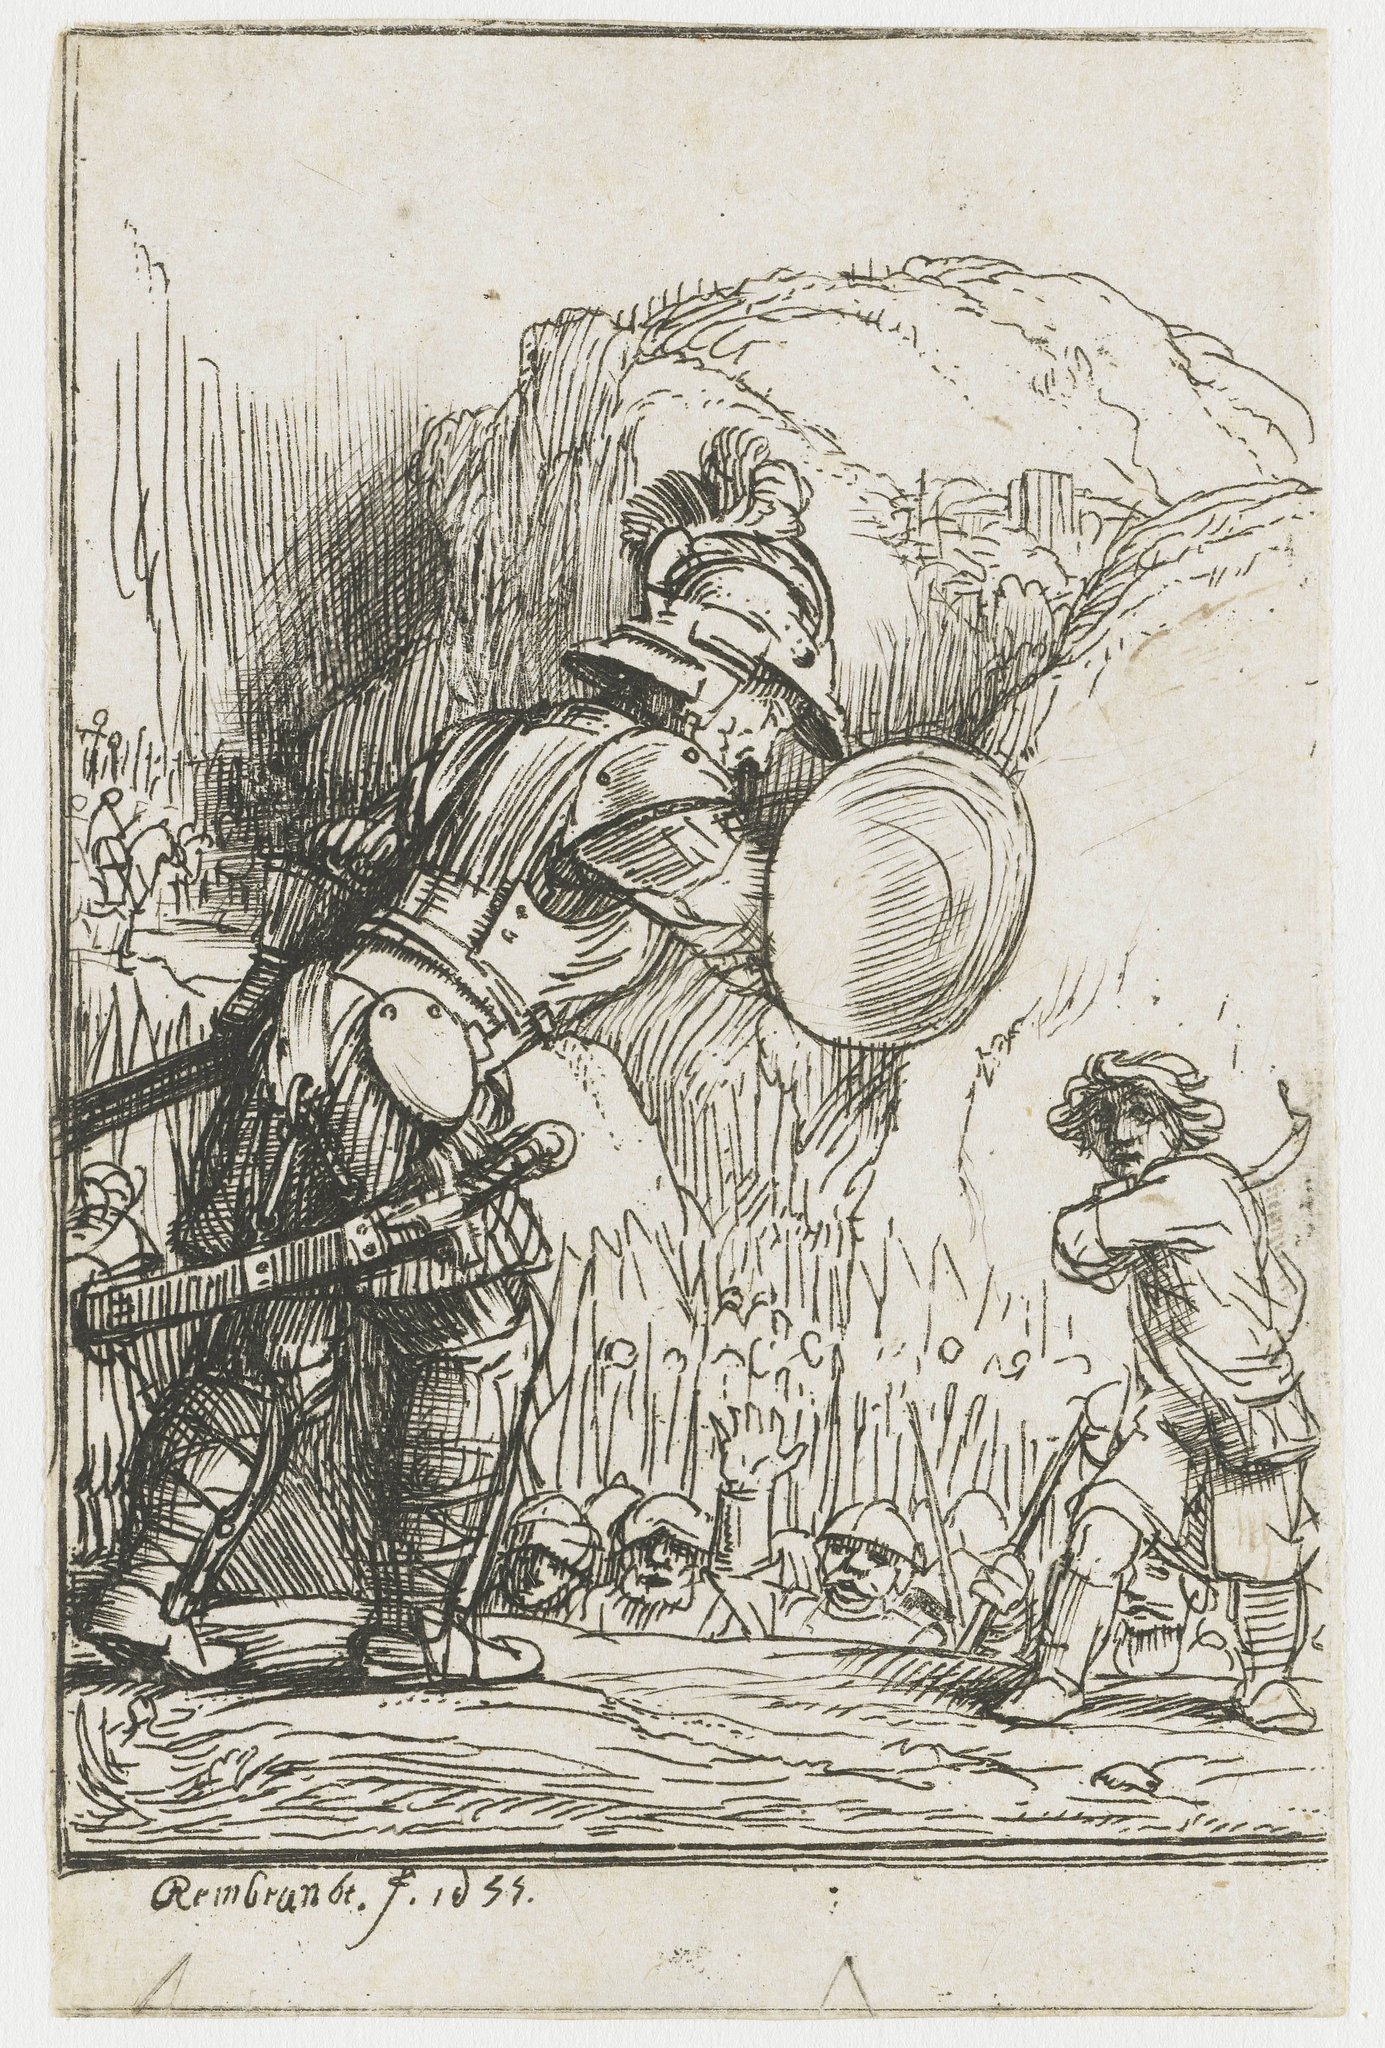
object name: print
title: David and Goliath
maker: rembrandt van rijn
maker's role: draughtsman, painter, print maker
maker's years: 1606-1669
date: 1655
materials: paper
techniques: drypoint, etching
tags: story of david and goliath (1 samuel 17)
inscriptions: inscription: ‘Collection Verstolk et de Kat’, collector's mark: Lugt 2228, signature and date: ‘Rembrandt f 1655’